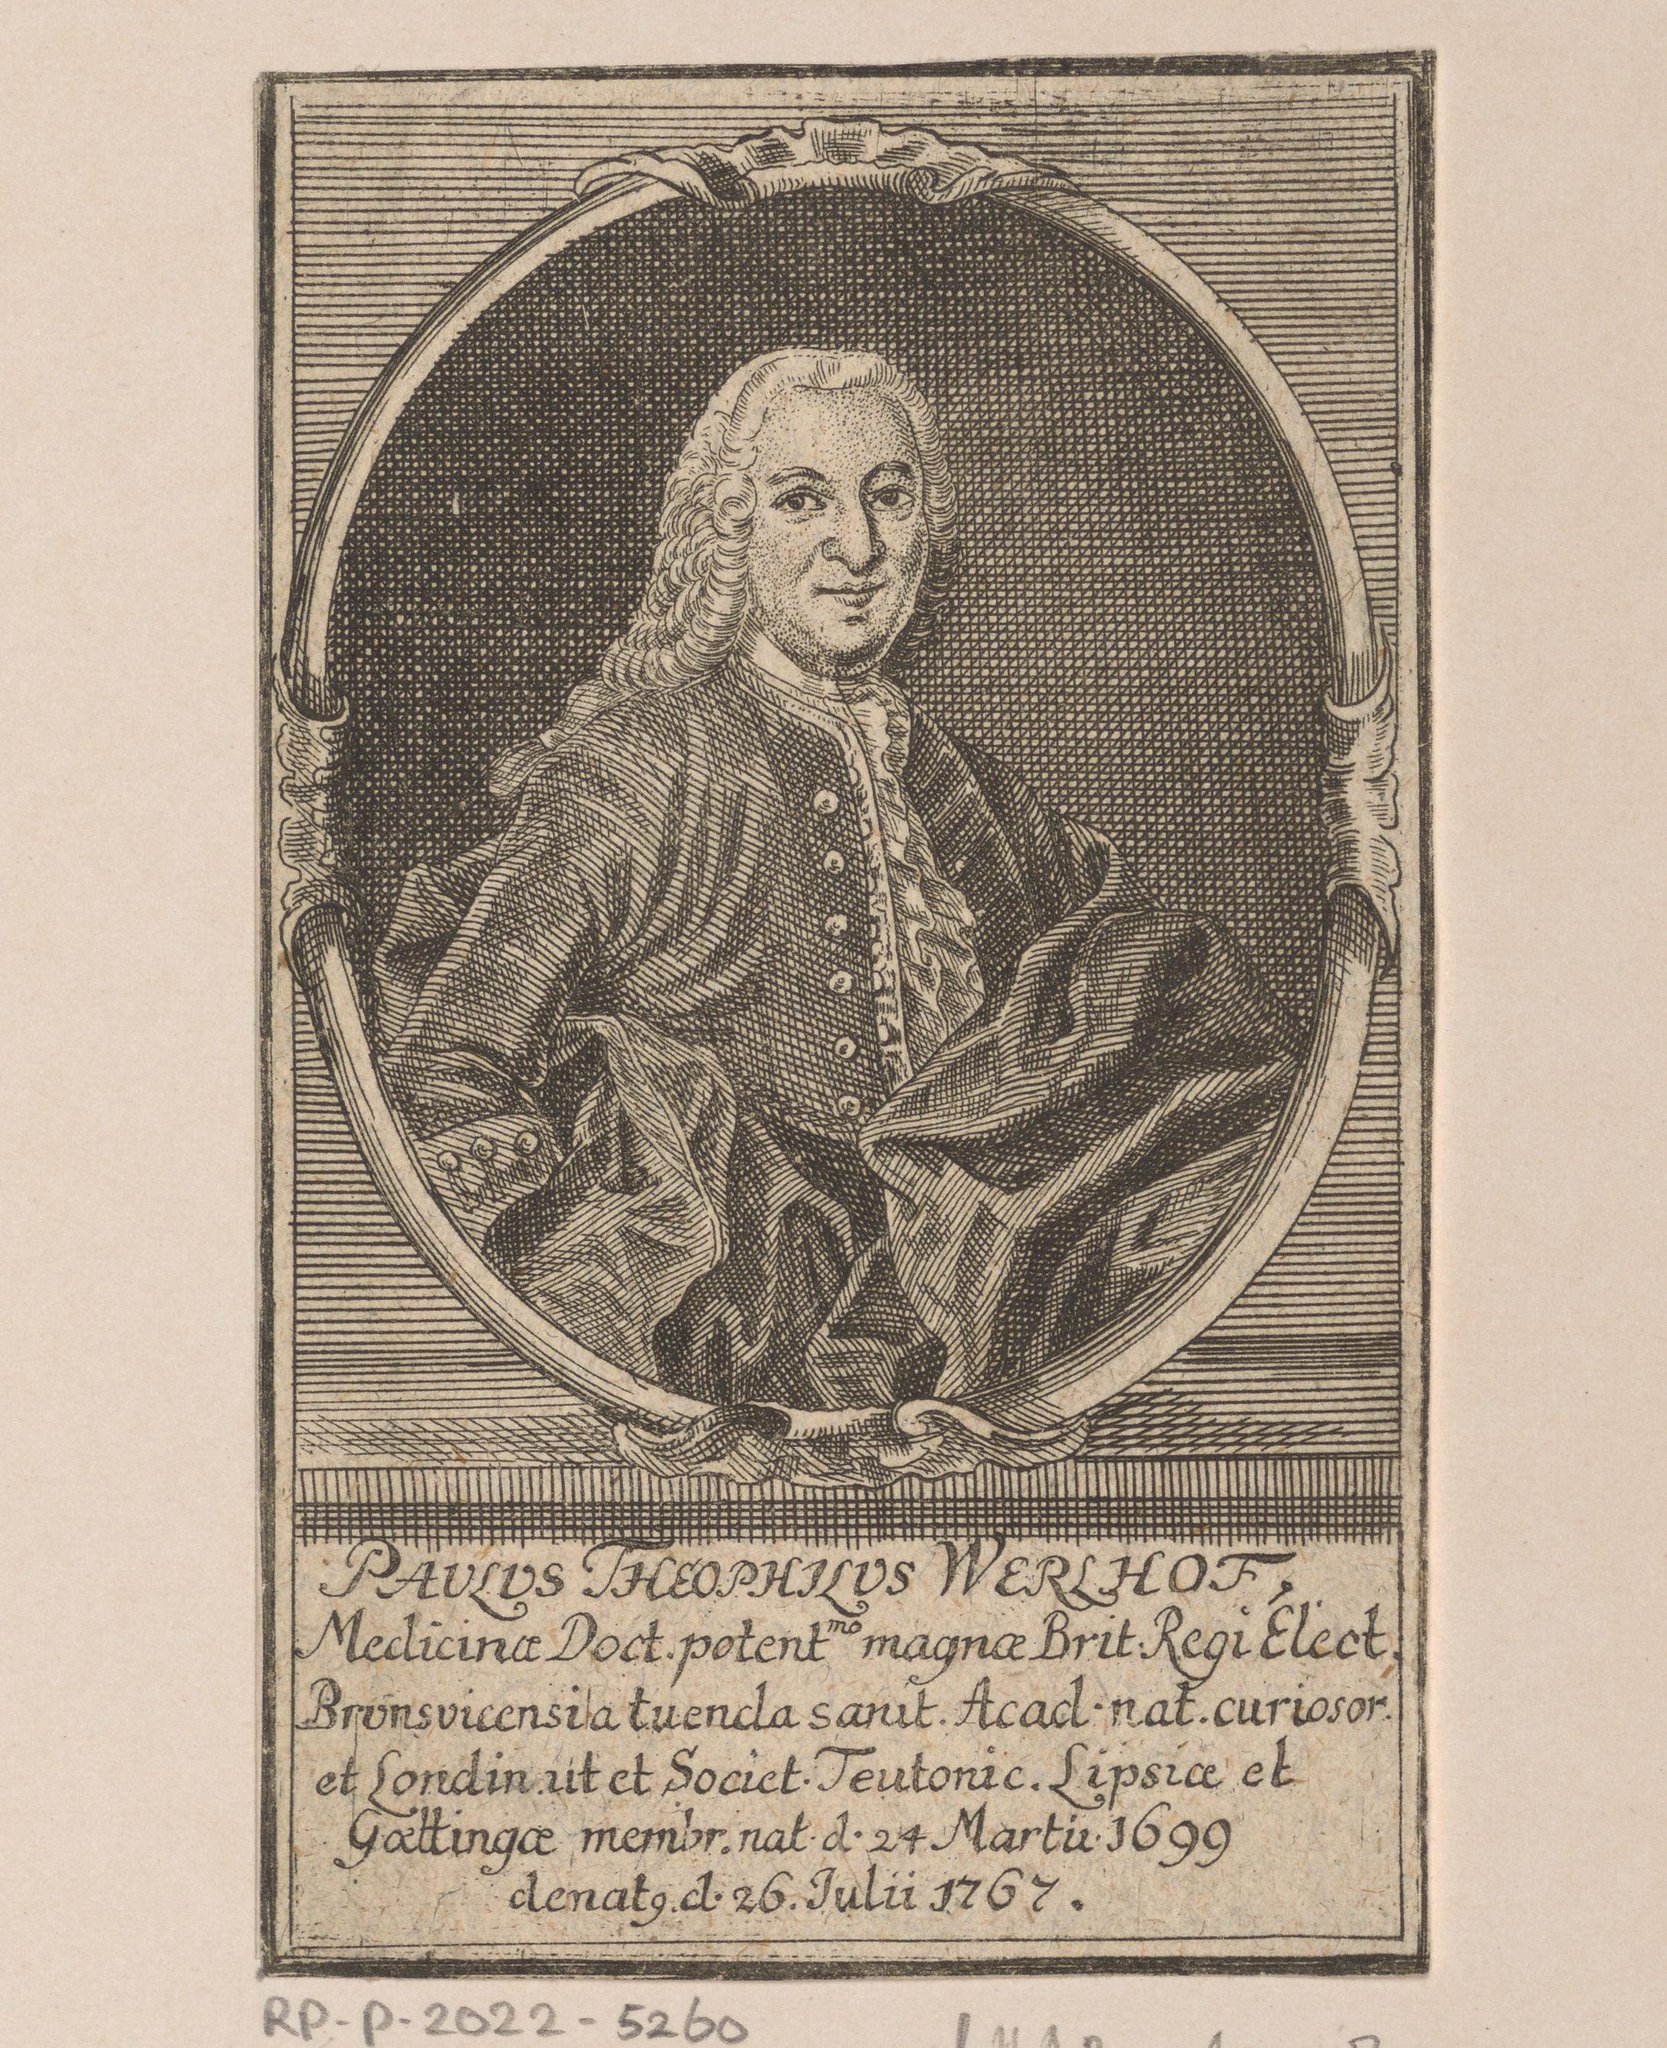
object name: print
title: Portret van Paul Gottlieb Werlhof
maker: Anonymous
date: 1767-1800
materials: paper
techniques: etching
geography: germany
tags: paul gottlieb werlhof, historical persons, portrait of a writer, physician, doctor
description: Met vijfregelig onderschrift in het Latijn.